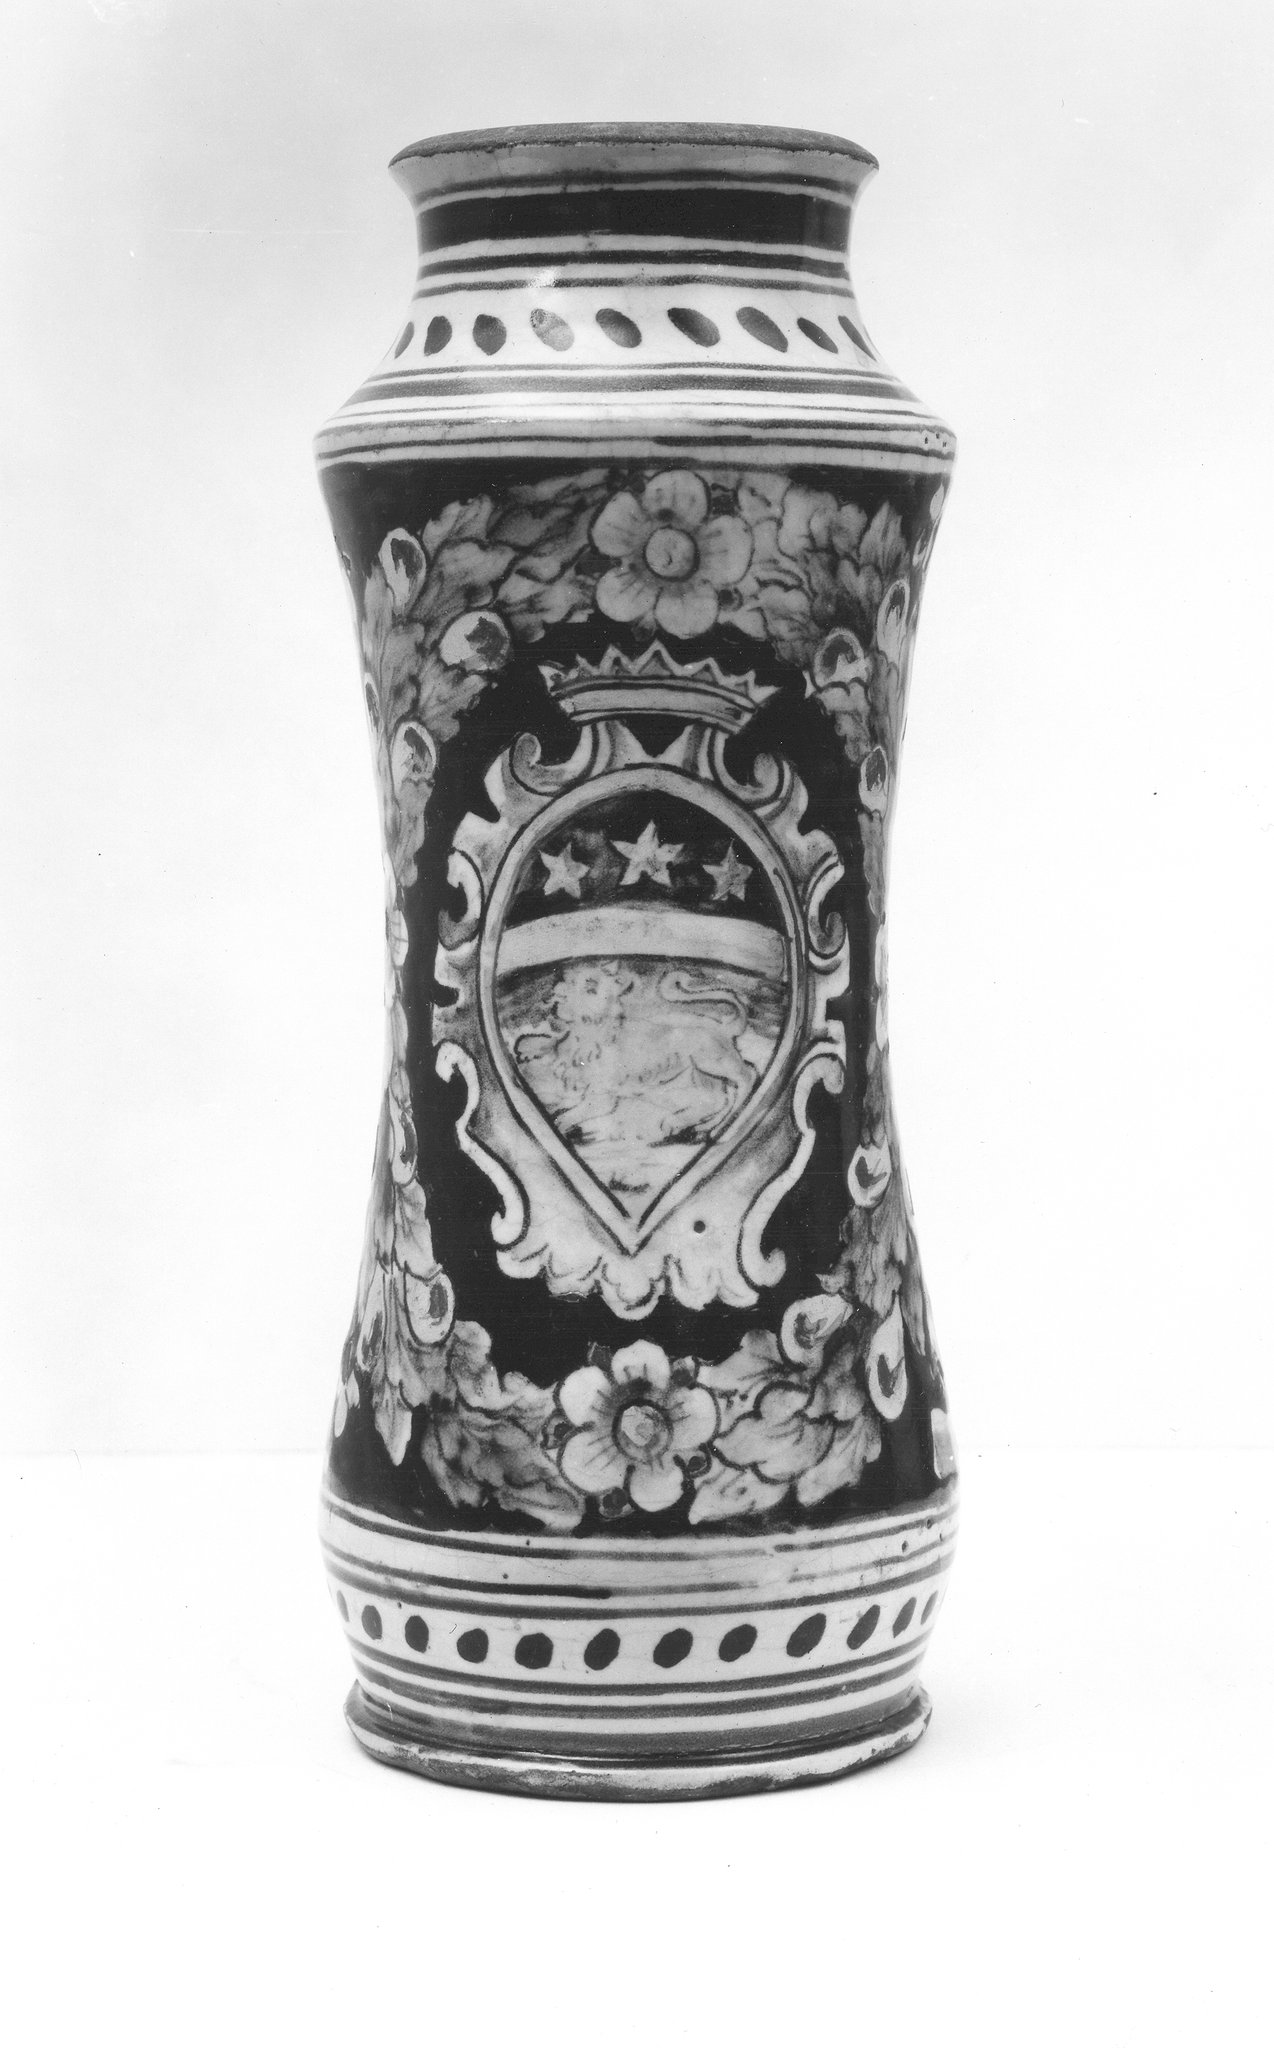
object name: albarello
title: Apothecary jar (albarello)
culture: italian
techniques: maiolica, glazing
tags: coat of arms